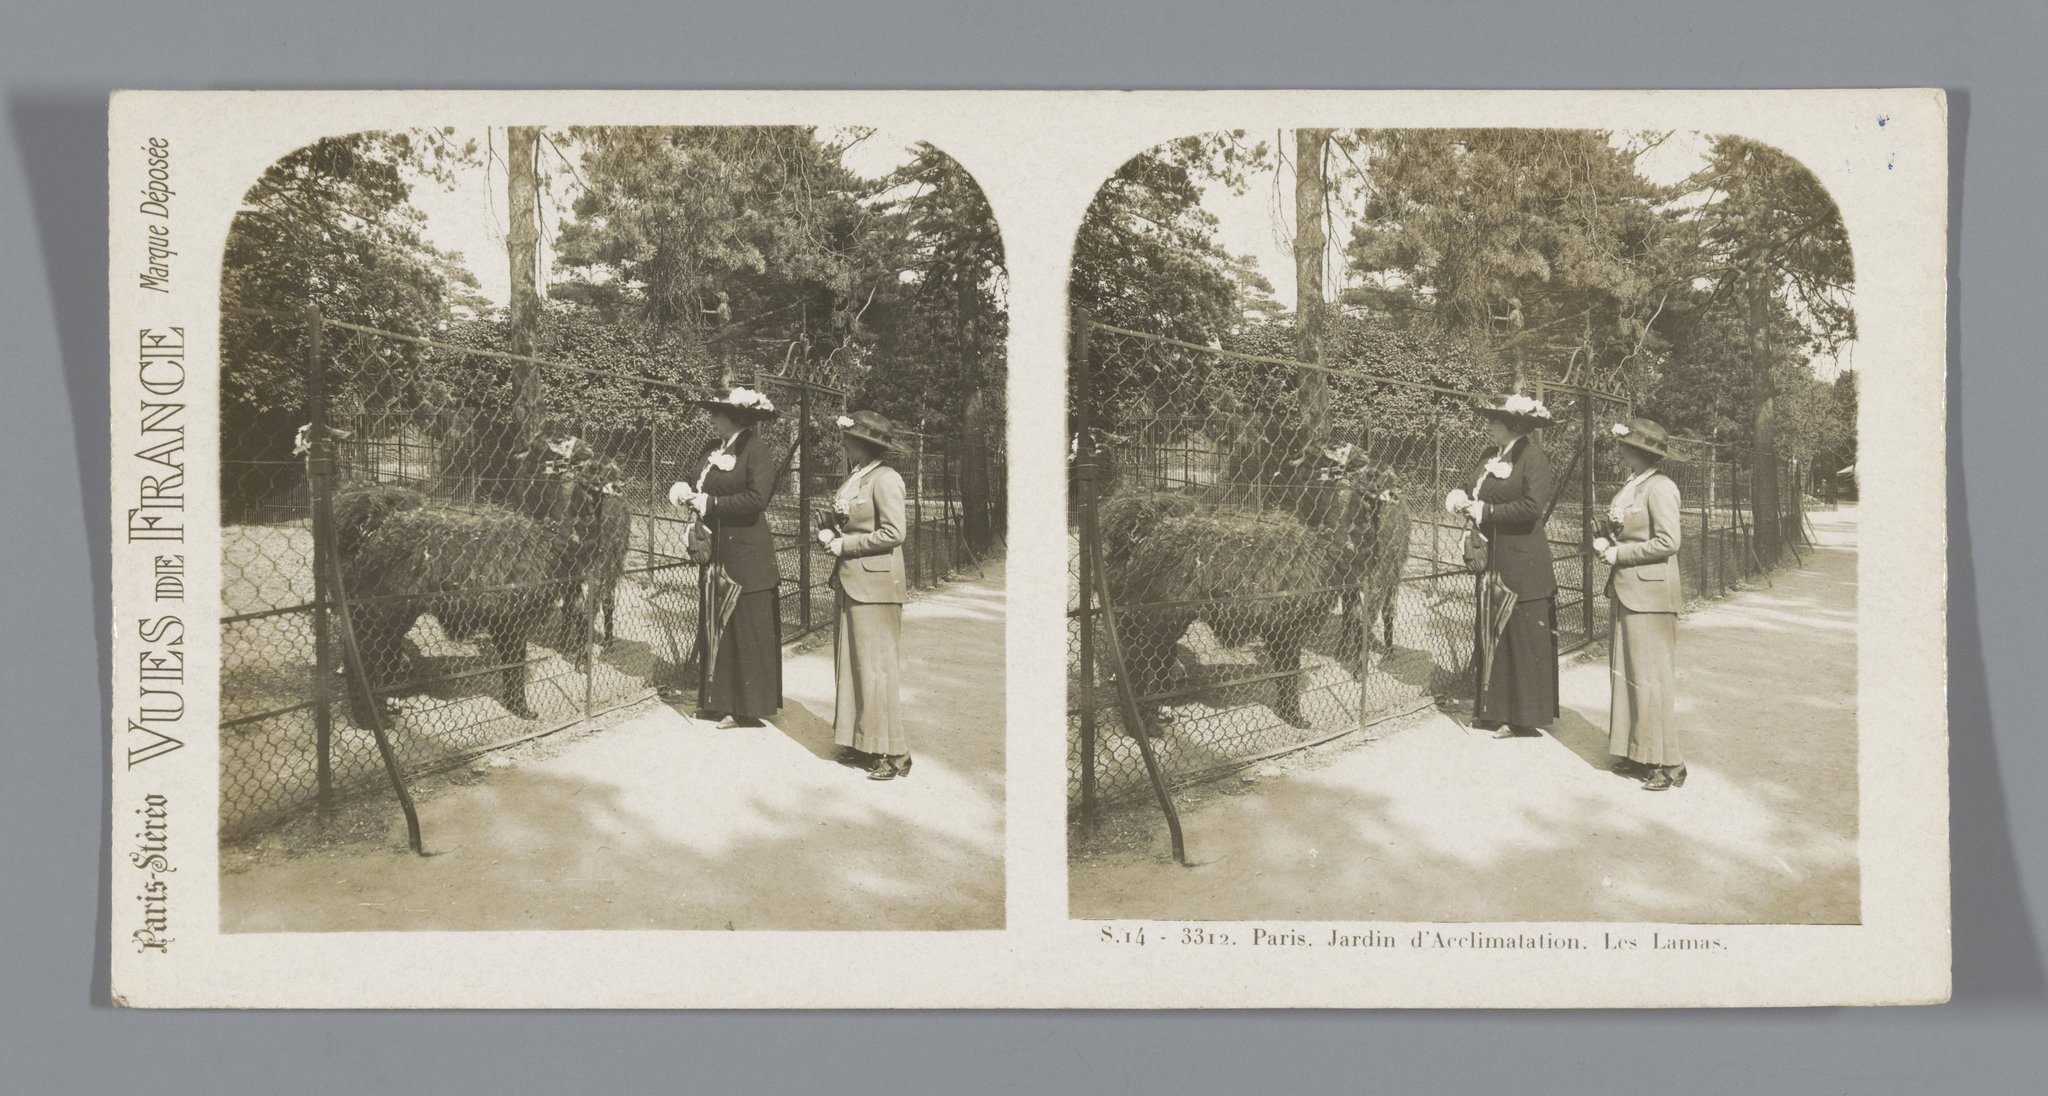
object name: stereograph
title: Paris-Stéréo Vues de France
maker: Anonymous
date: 1905-1930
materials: cardboard, photographic support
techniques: gelatin silver print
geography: jardin d'acclimatation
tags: hoofed animals, zoological garden, zoo, seen as place where non-domestic animals are kept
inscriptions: number: ‘S.14 - 3312.’